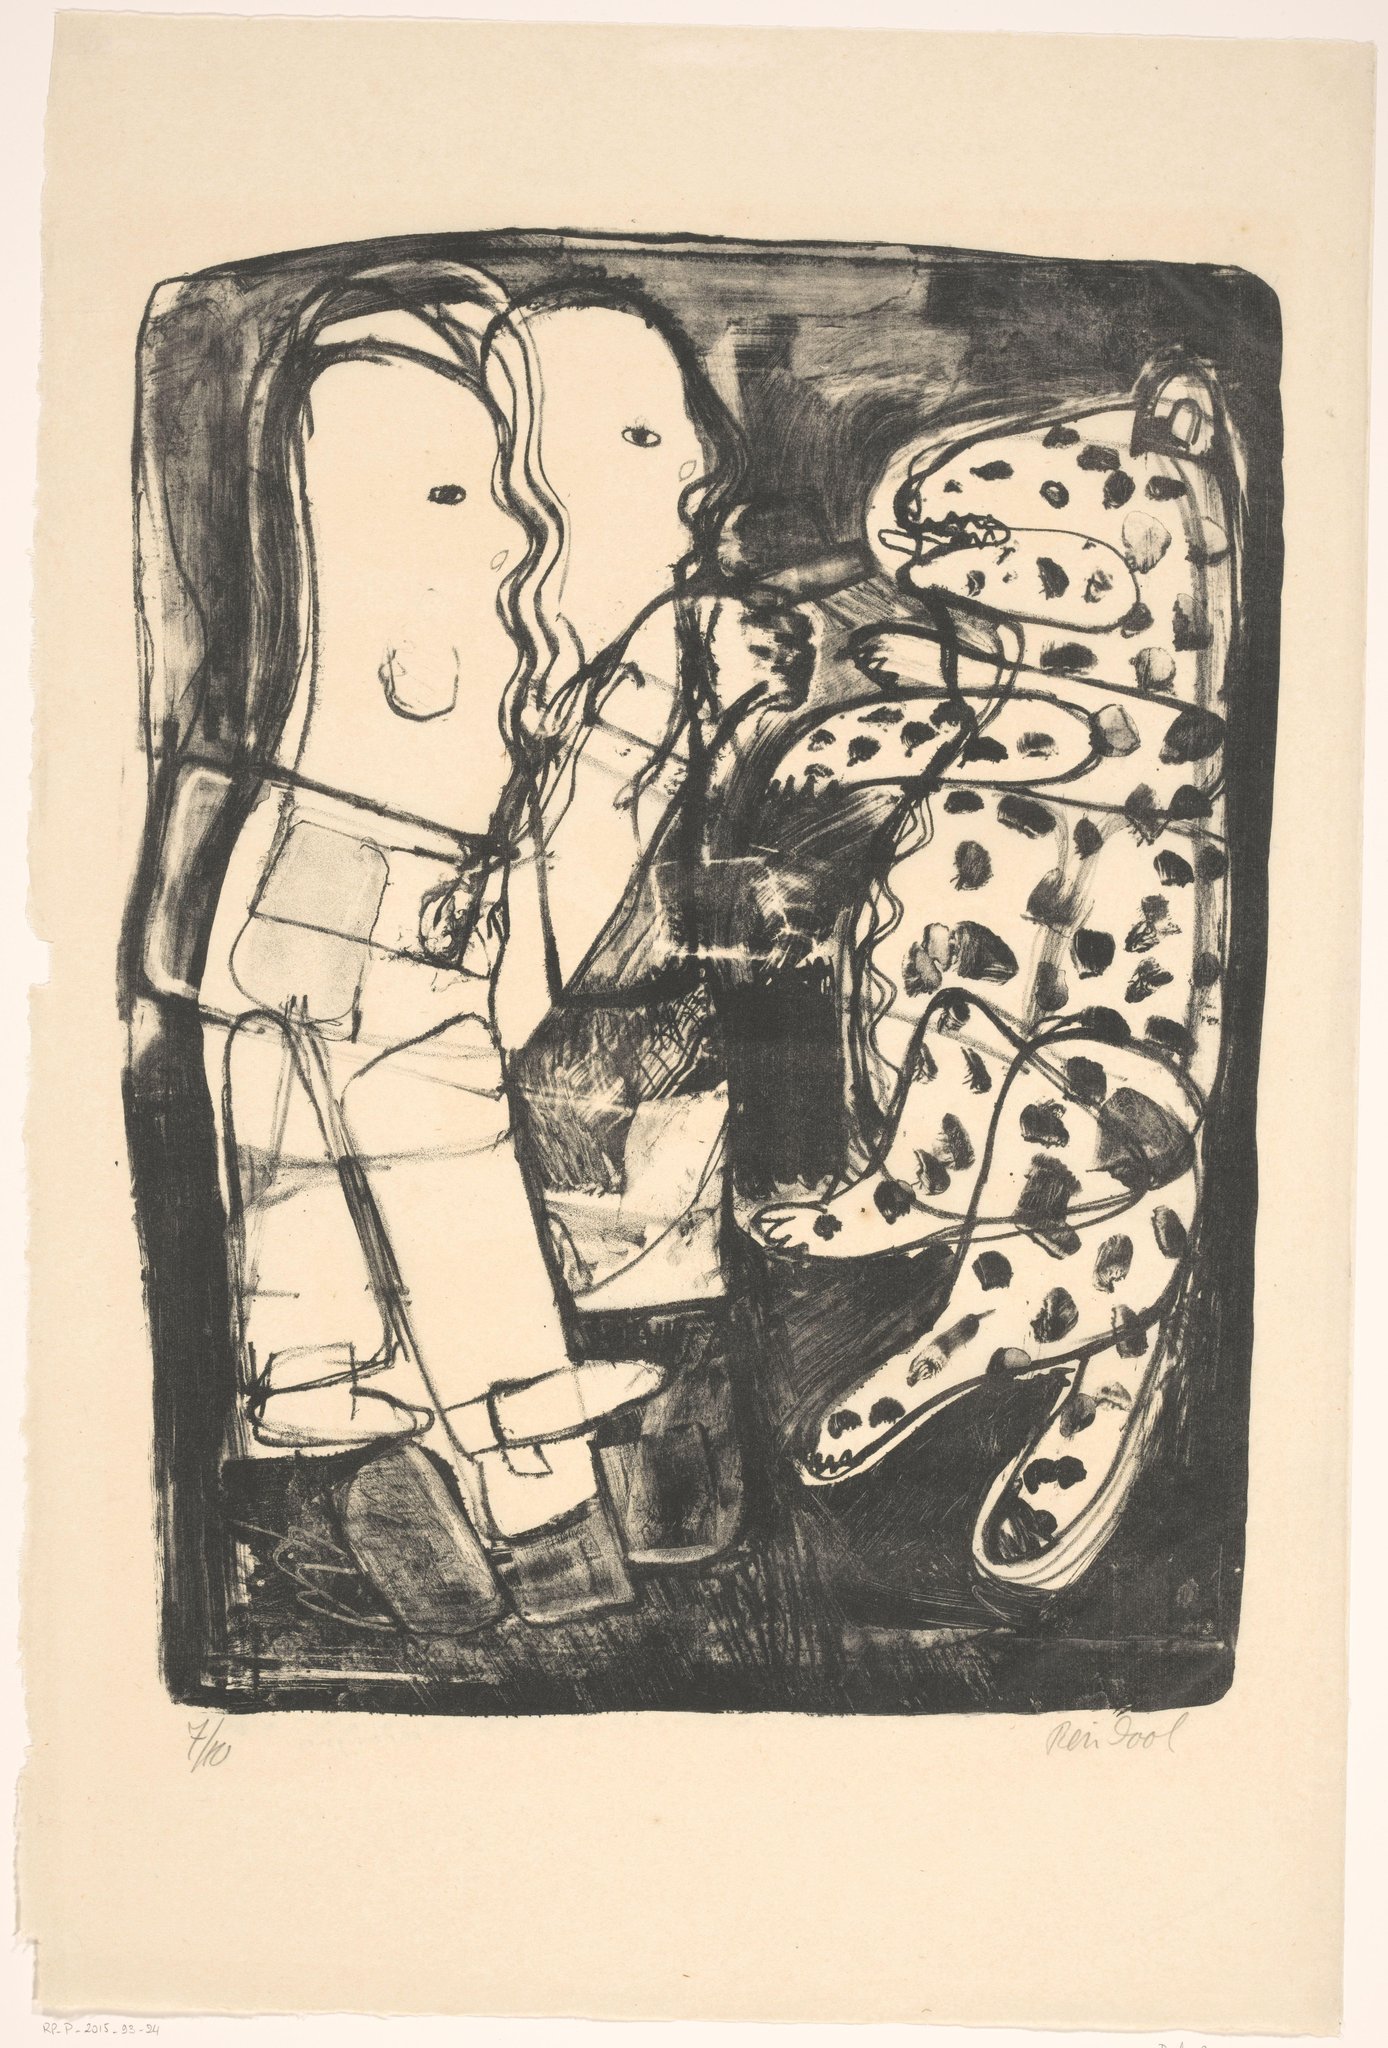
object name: print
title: Mannen met luipaard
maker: rein dool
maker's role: draughtsman, painter, print maker, sculptor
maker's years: 1933-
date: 1970-1980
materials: paper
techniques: lithograph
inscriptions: signature